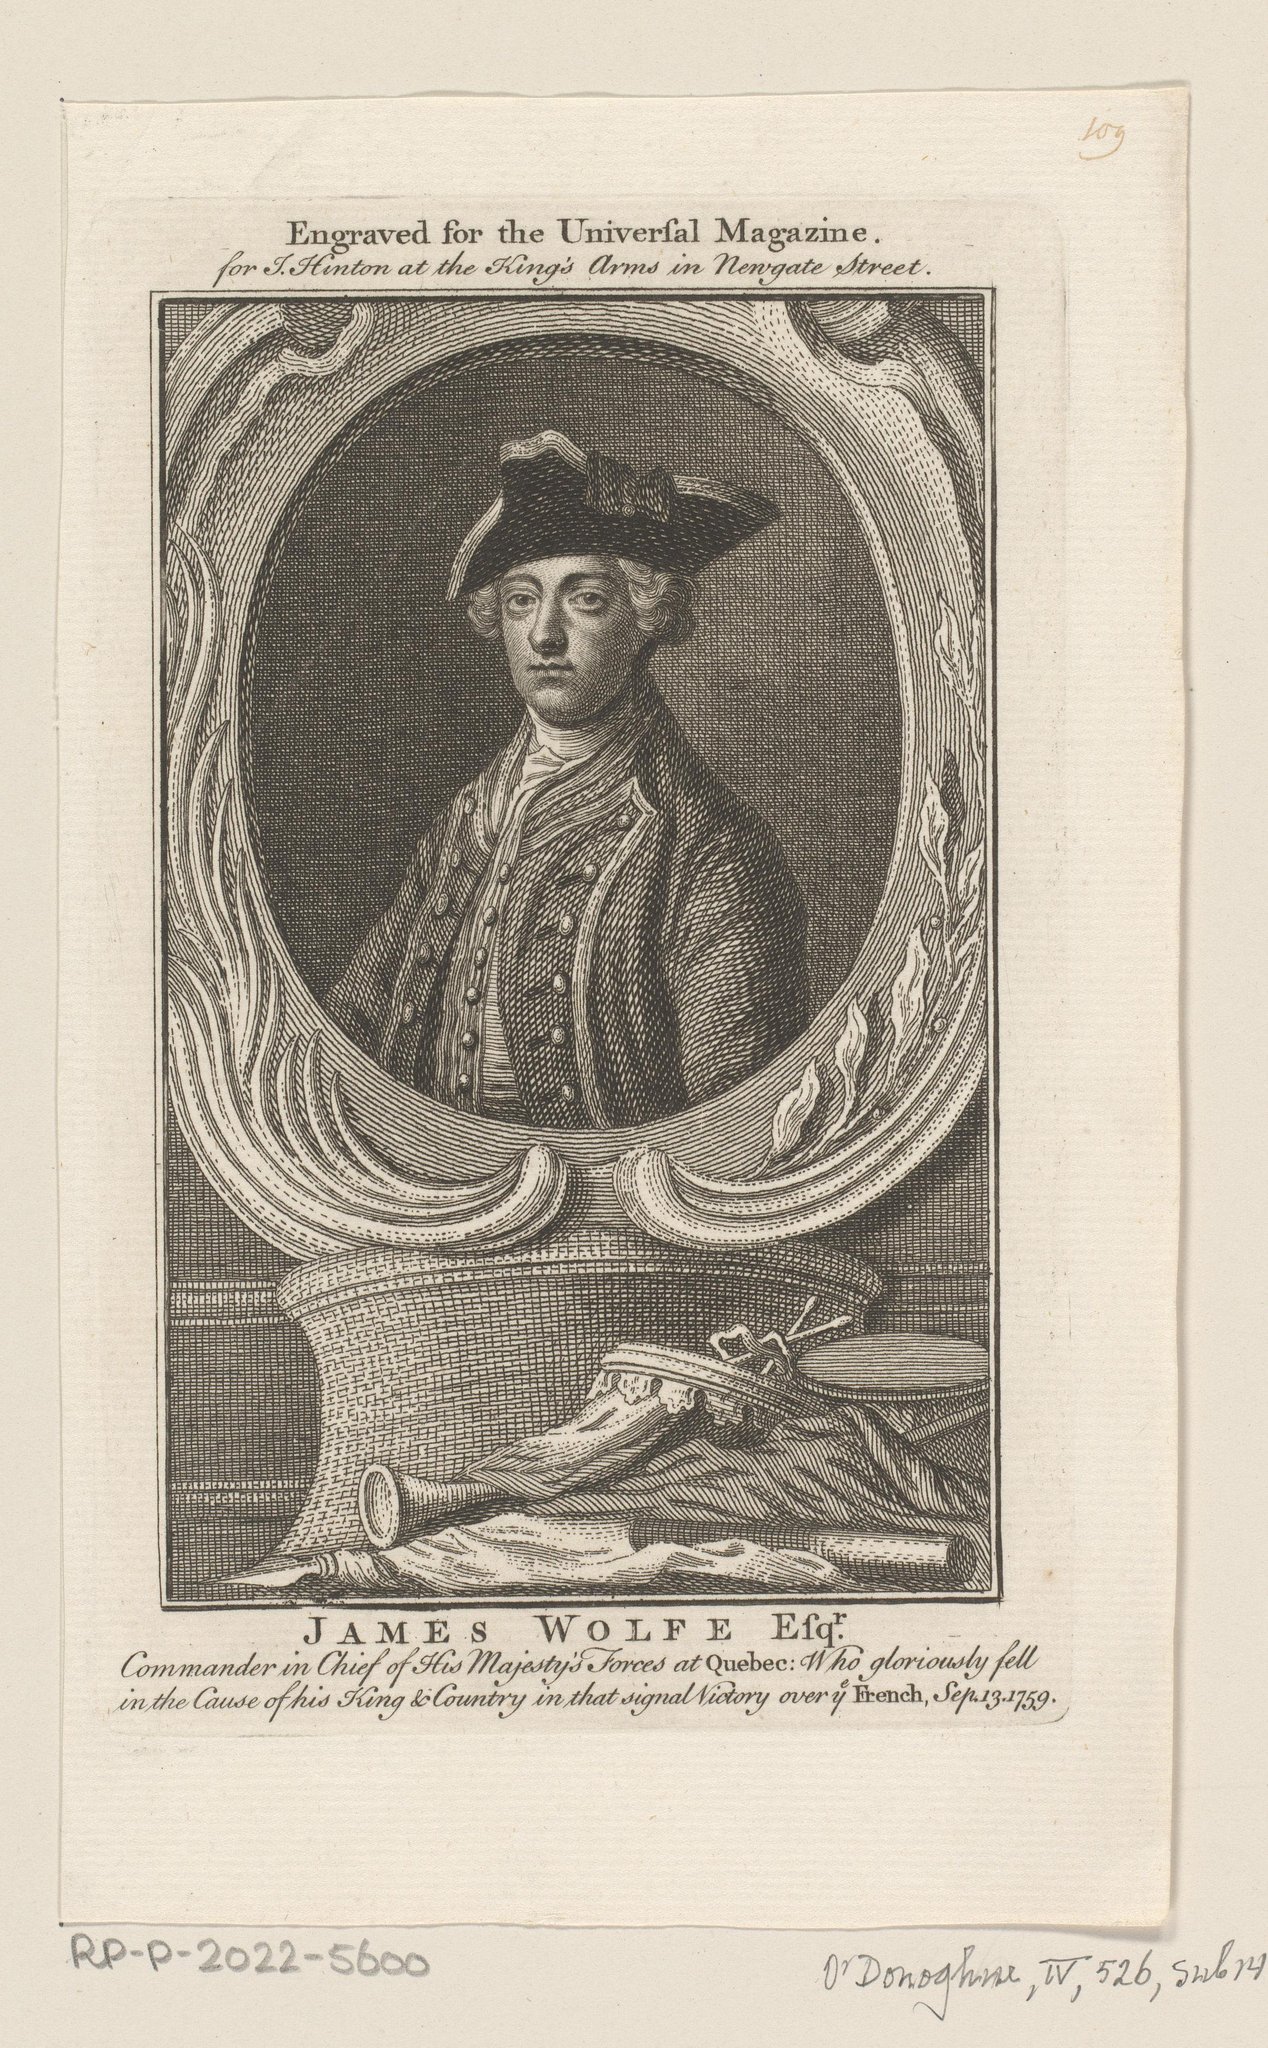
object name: book illustration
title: Portret van James Wolfe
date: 1759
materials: paper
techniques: engraving, etching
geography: london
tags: québec, commander-in-chief, general, marshal, historical persons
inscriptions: number: ‘109’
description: Prent waarschijnlijk uit: The Universal Magazine. Londen: J. Hinton, 1759, dl. 25.